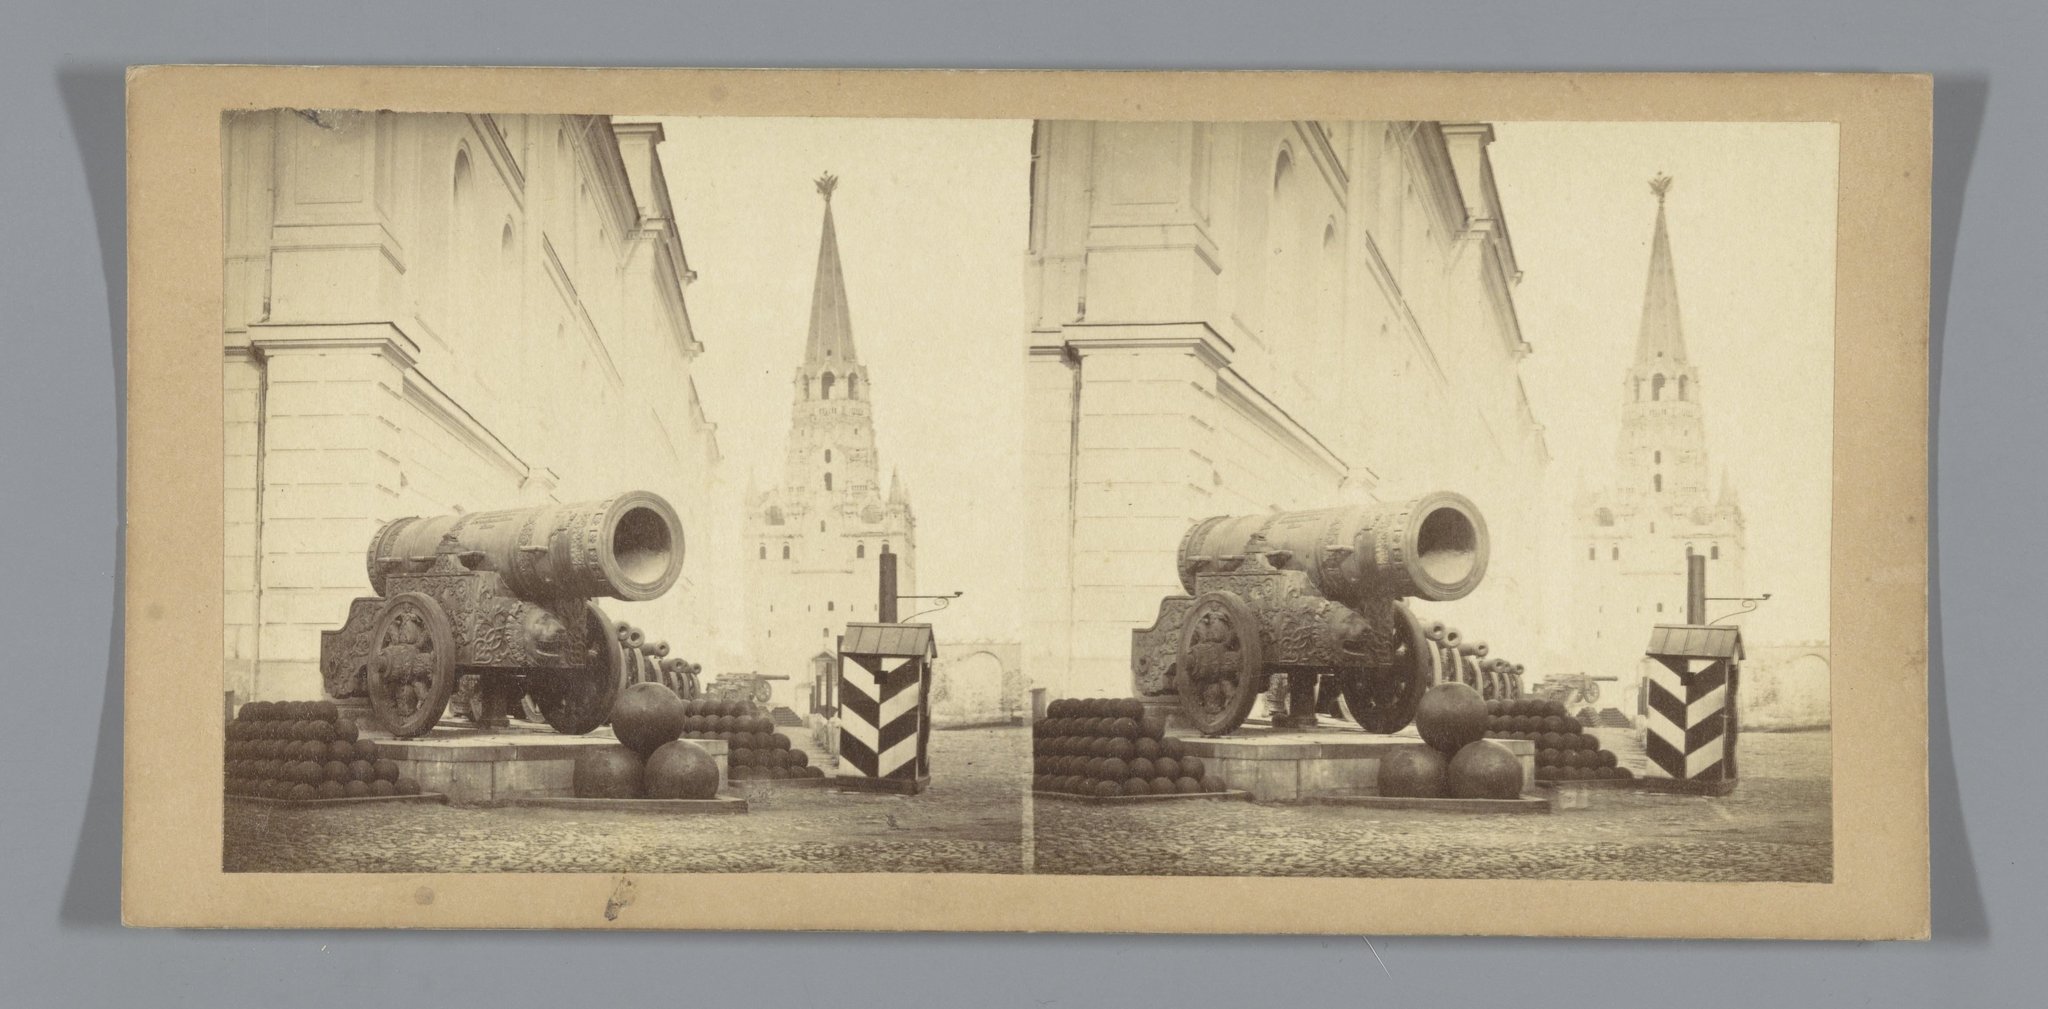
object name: stereograph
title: Tsarenkanon in het Kremlin van Moskou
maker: Anonymous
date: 1850-1880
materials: cardboard, photographic support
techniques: albumen print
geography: kremlin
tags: firearms: cannon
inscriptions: inscription: ‘Grand canon dans le Kremlin’, number: ‘D. 8.’